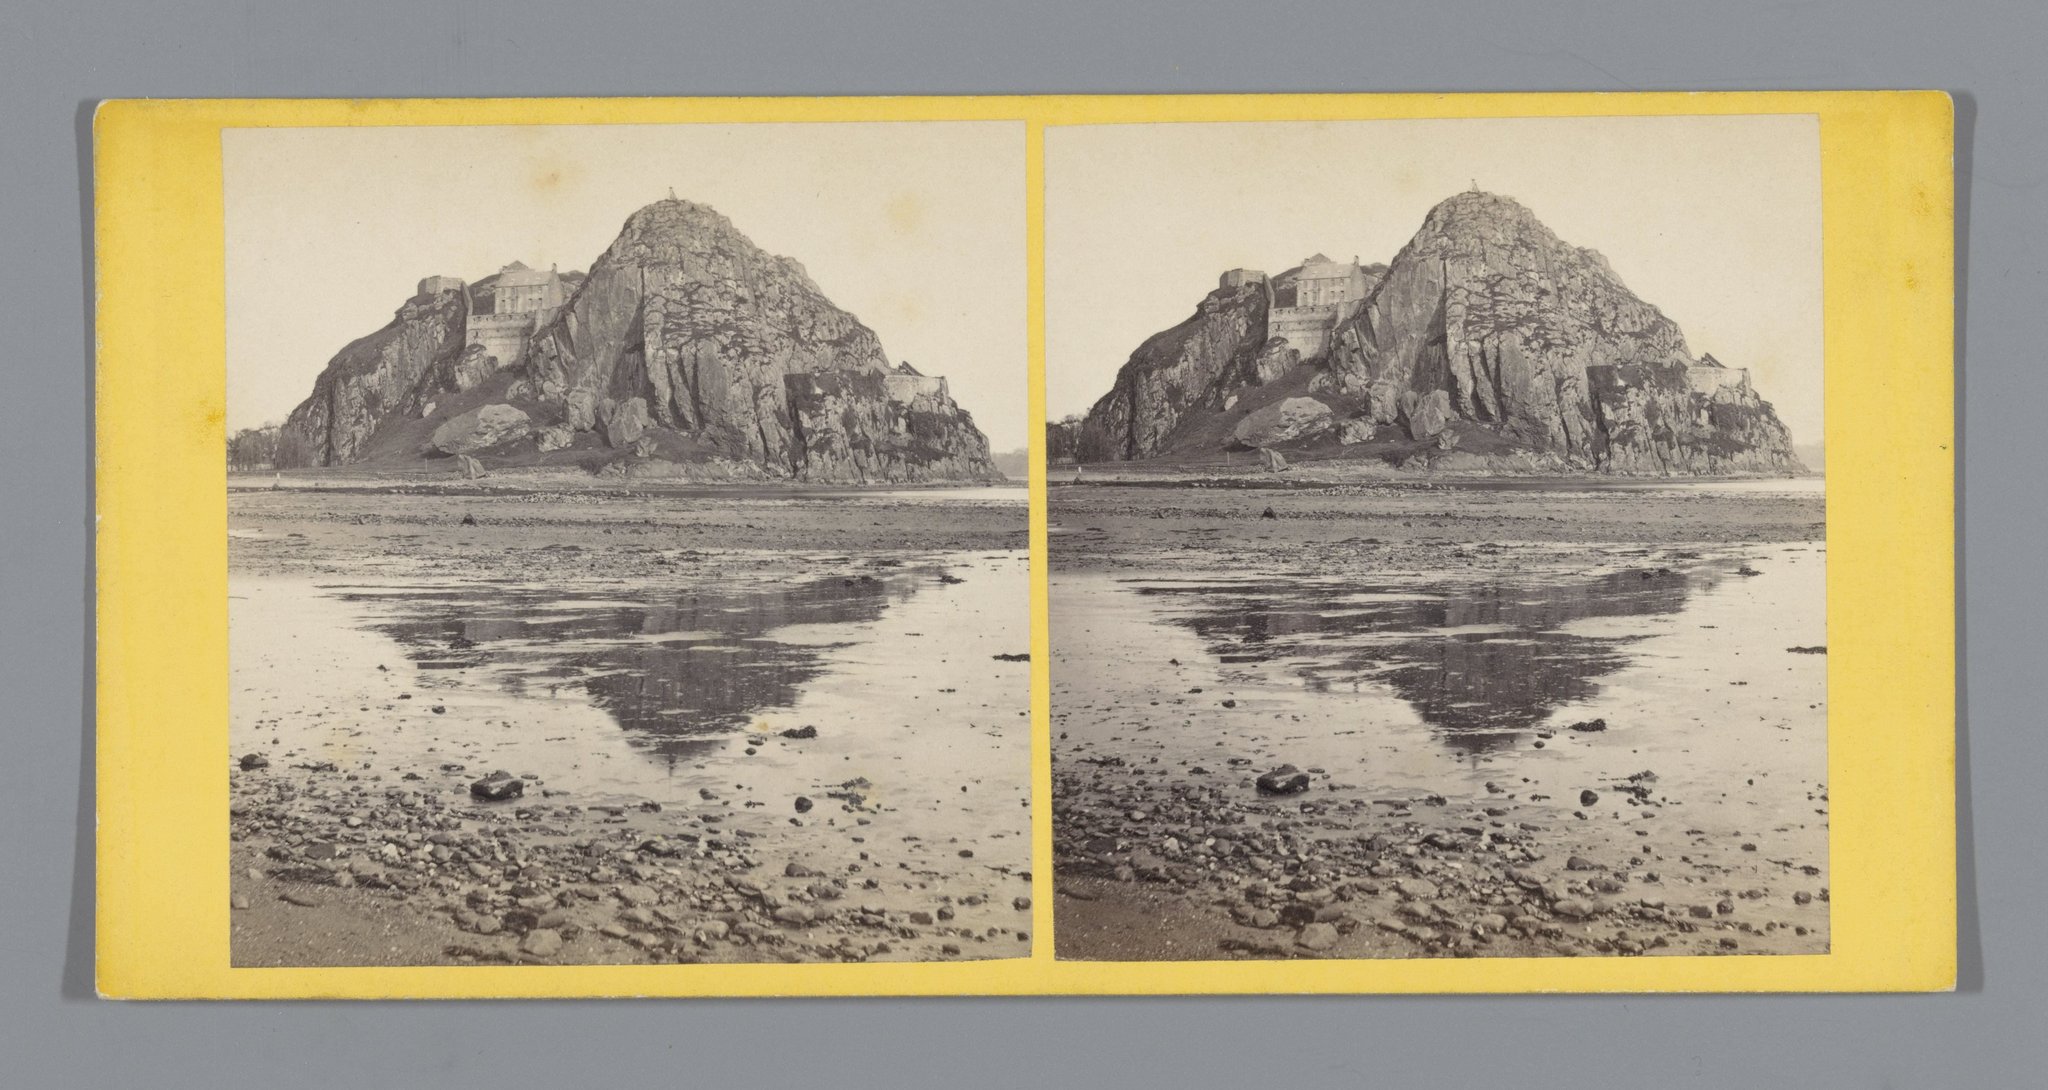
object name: stereograph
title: Dumbarton Rock and Castle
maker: george washington wilson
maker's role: publisher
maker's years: 1823-1893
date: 1858-1872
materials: cardboard, photographic support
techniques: albumen print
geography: dumbarton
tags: landscape with tower or castle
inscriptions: number: ‘No. 791.’